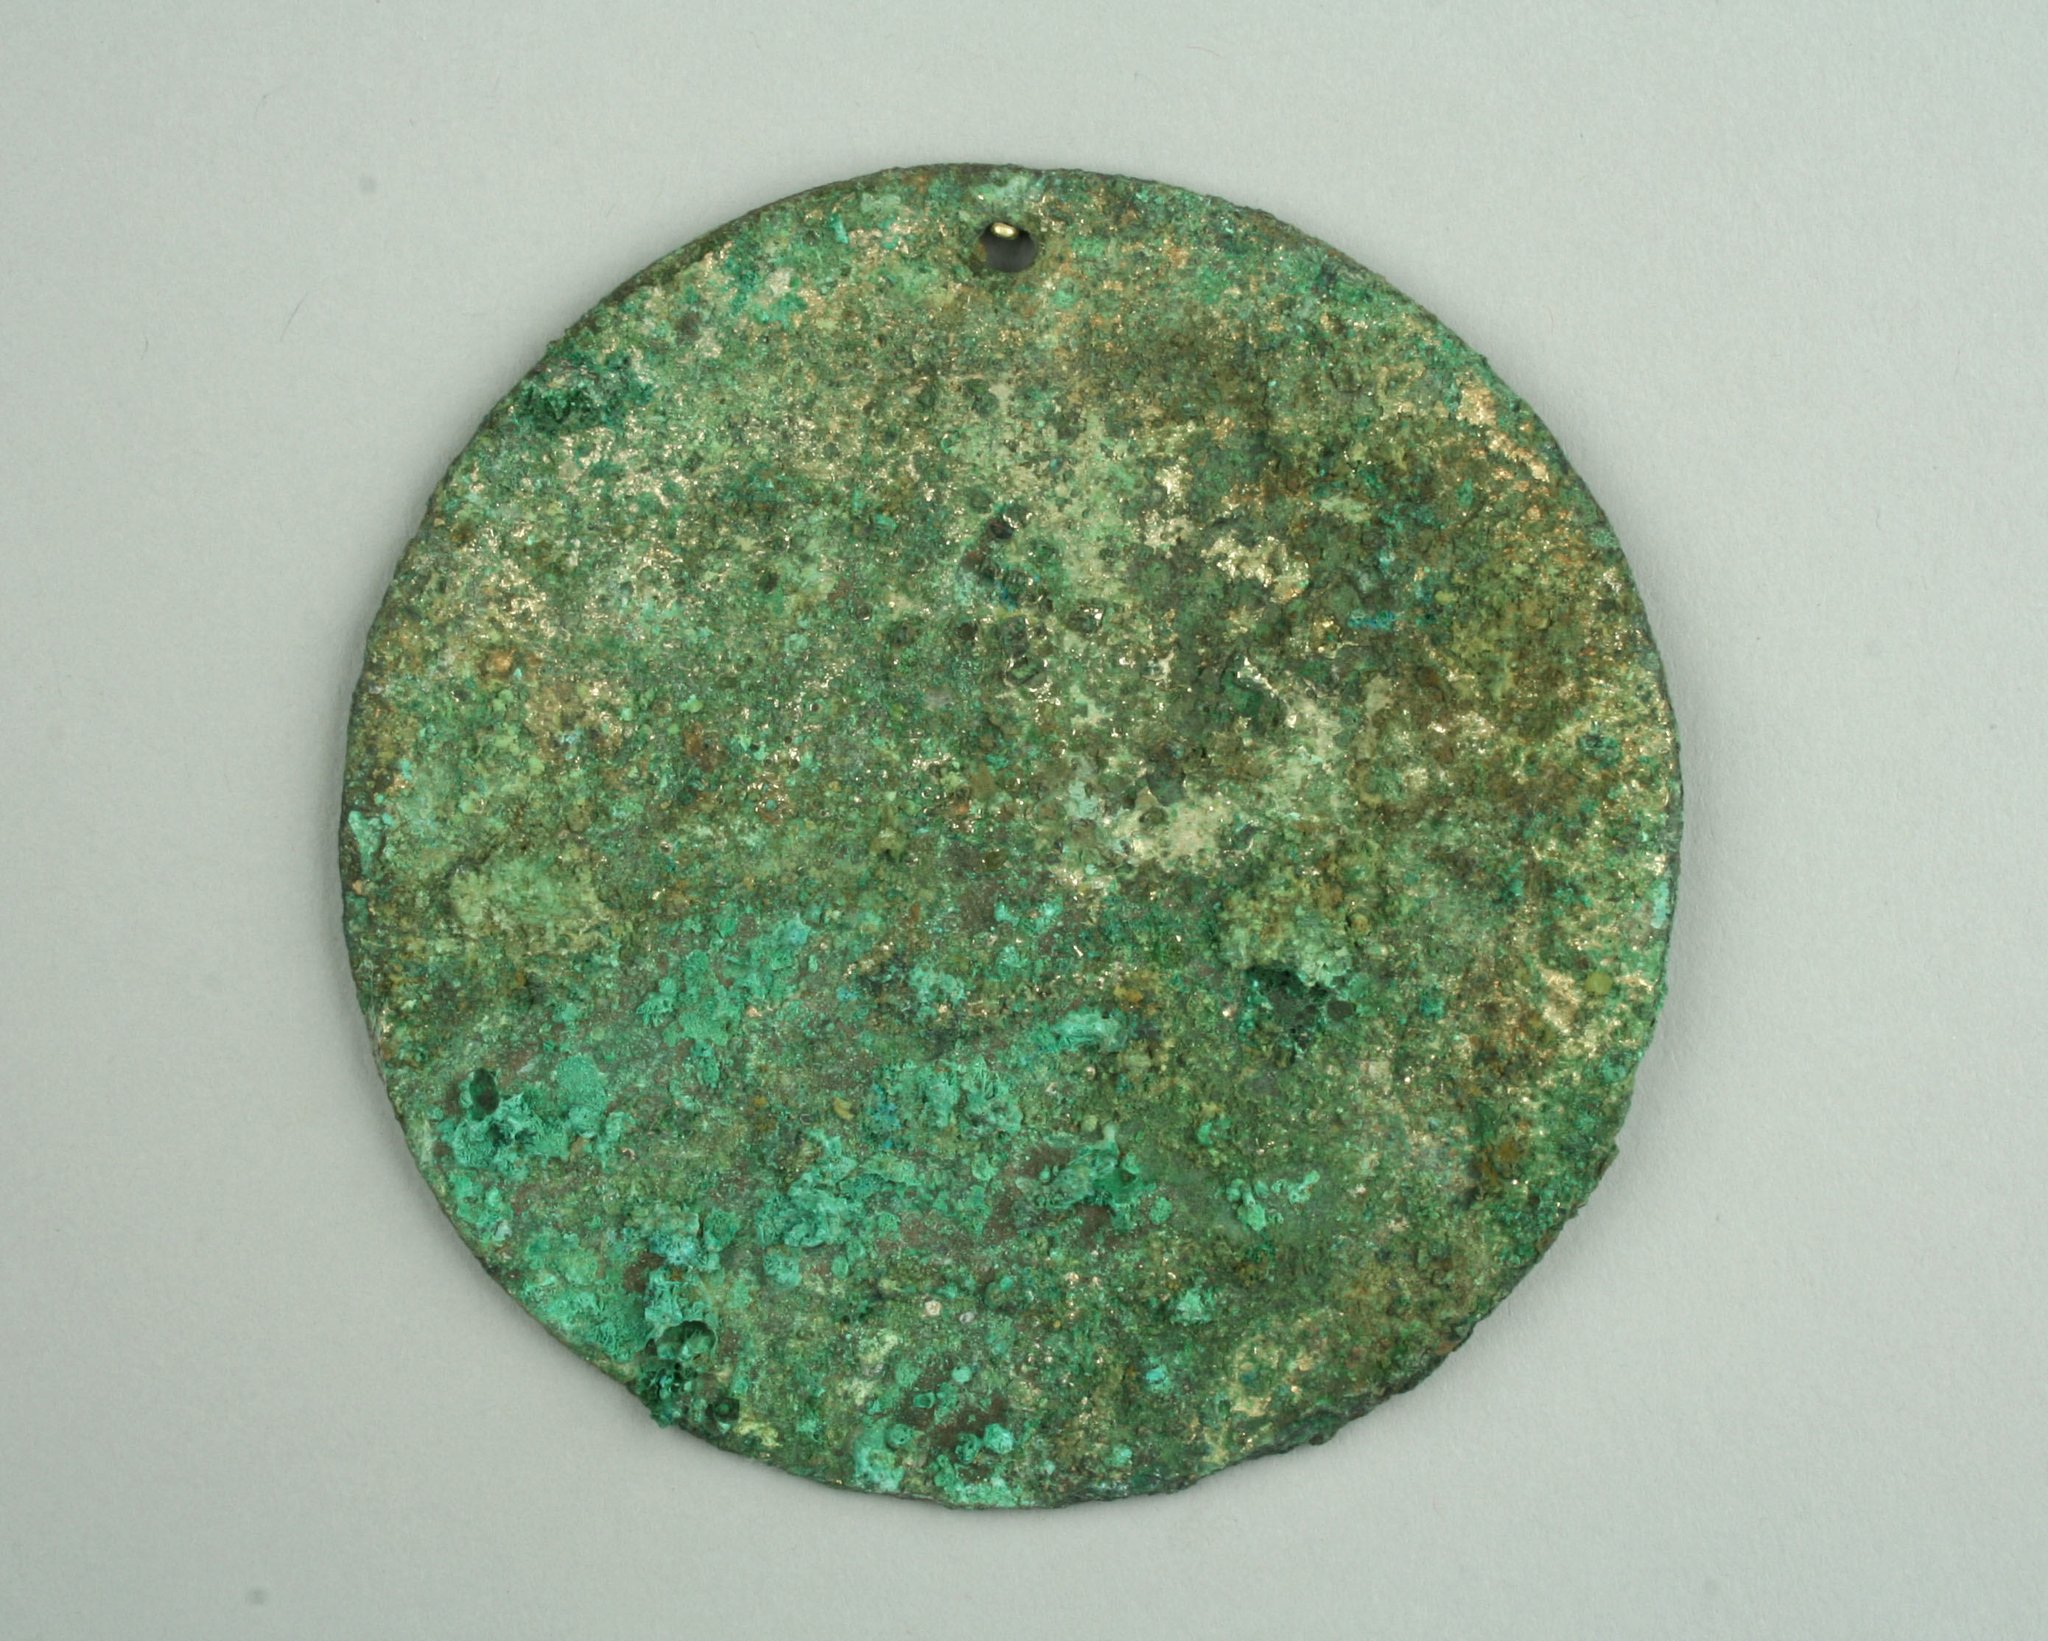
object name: plaque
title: Round Plaque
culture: vicús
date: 300 BCE-200 CE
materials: copper, gilt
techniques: hammering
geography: peru